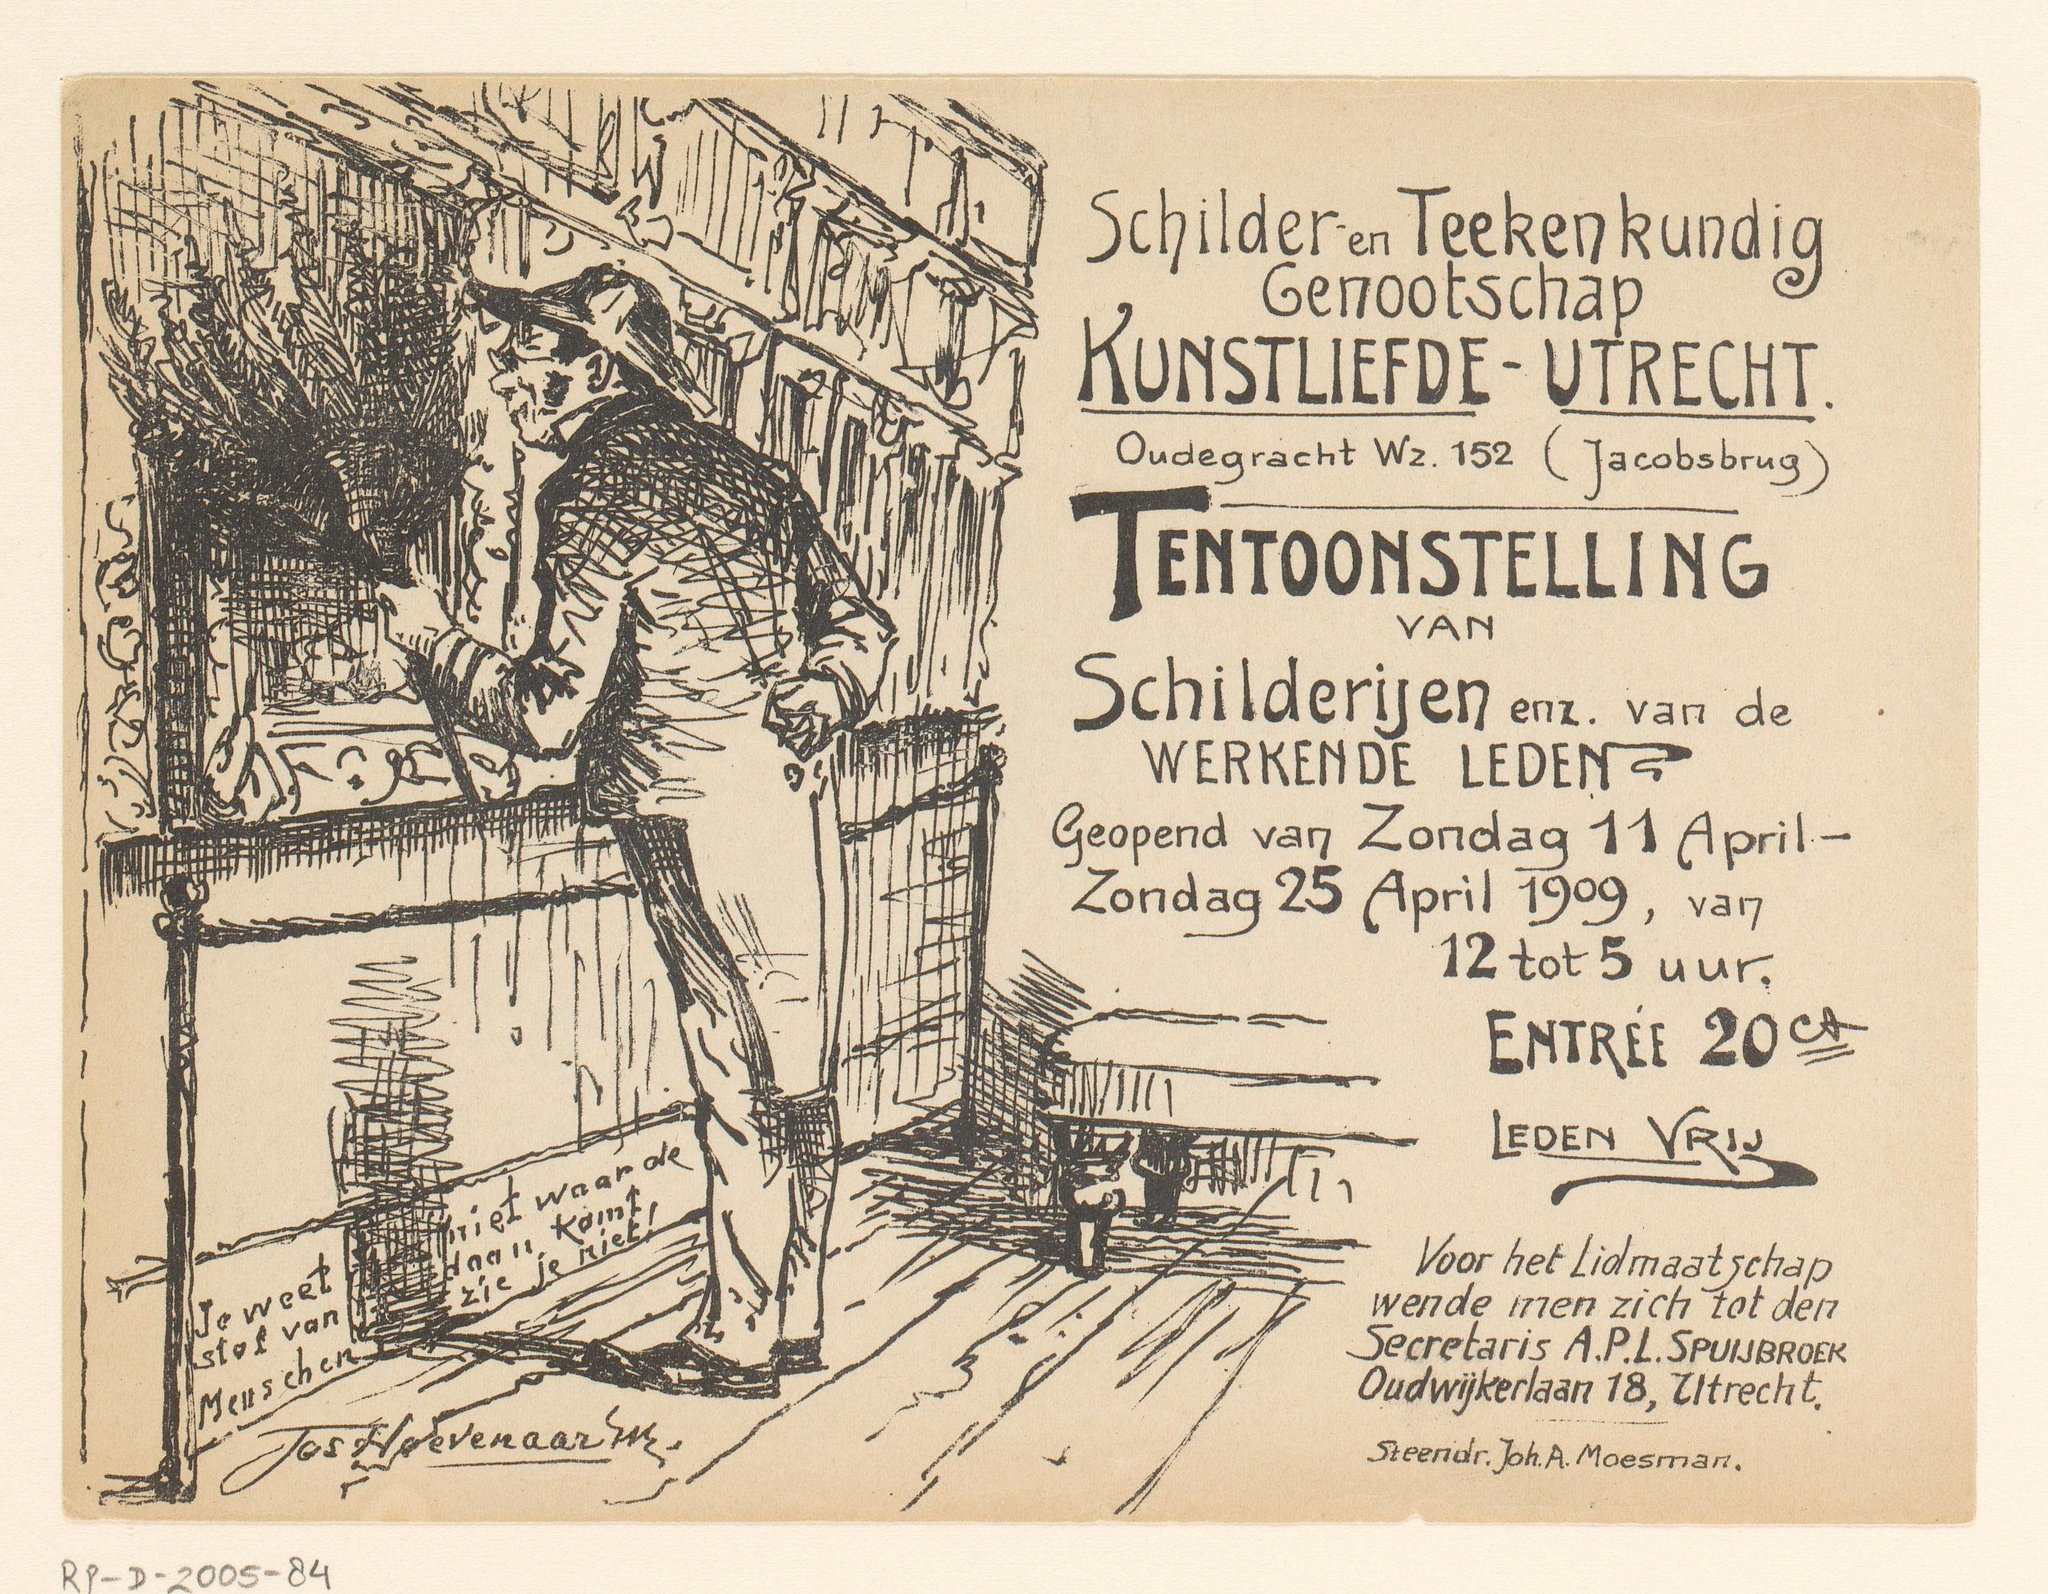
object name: print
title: Uitnodiging van Schilder- en Teekenkundig Genootschap "Kunstliefde" voor een tentoonstelling van schilderijen van de werkende leden, 11-25 april 1909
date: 1904-1909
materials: paper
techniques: lithograph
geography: netherlands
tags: criticizing and discussing art, art criticism, dusting, circle, club of artists, collecting and exhibiting products of the fine arts, picture, painting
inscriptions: collector's mark: Lugt 2228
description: Man stoft een schilderij af met een plumeau. Uitnodiging van Schilder- en Teekenkundig Genootschap "Kunstliefde" voor een tentoonstelling van schilderijen etc. van de werkende leden, 11-25 april 1909.